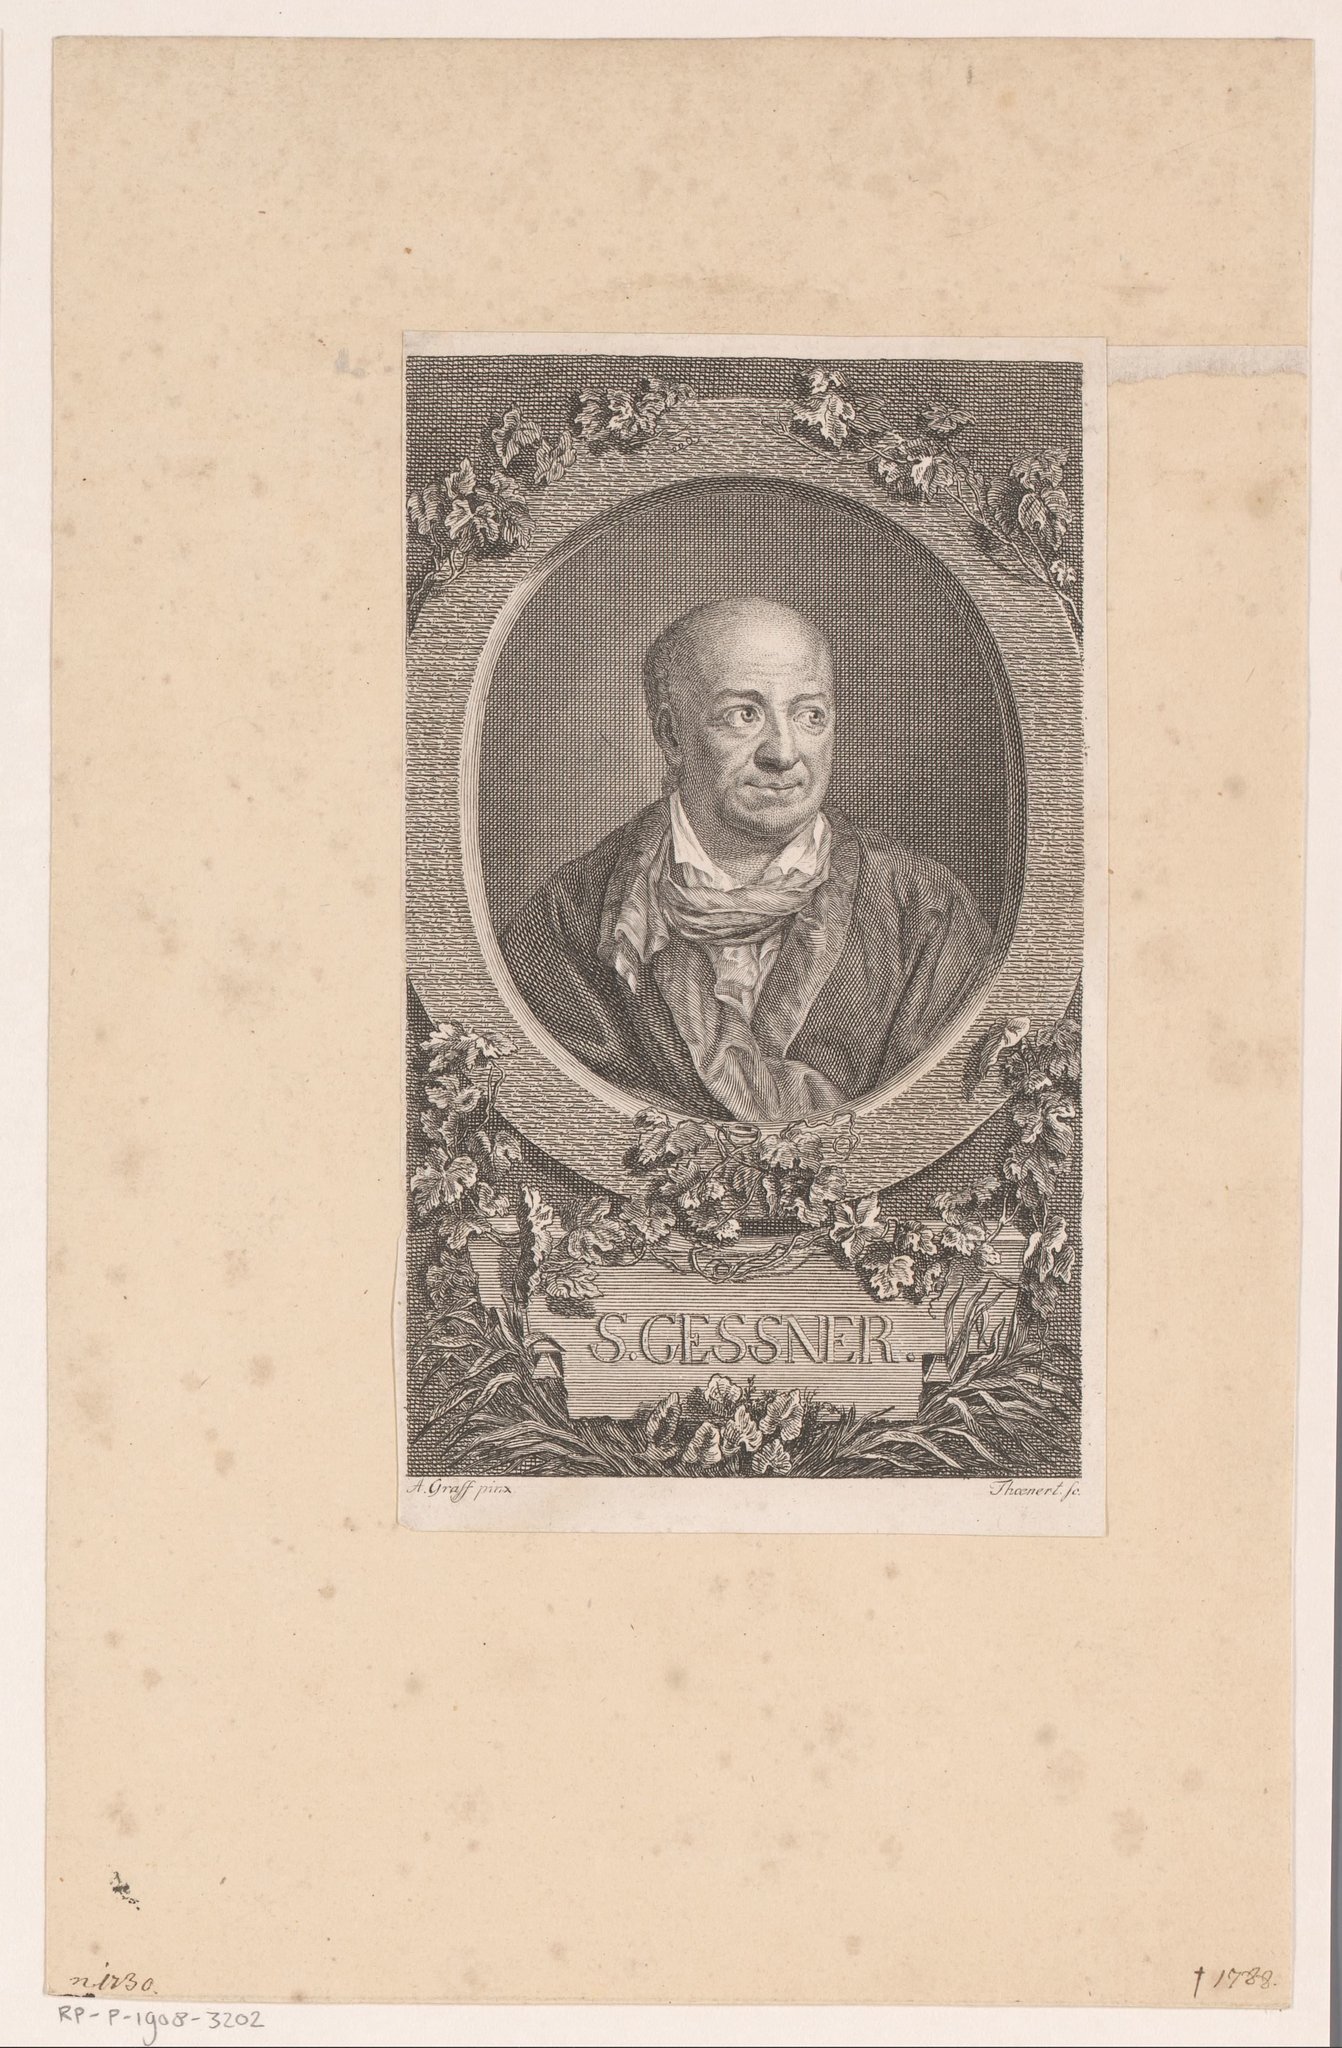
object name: print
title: Portret van Salomon Gesner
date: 1764-1814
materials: paper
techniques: engraving, etching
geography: germany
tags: painter, print maker, salomon gessner, historical persons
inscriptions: collector's mark: Lugt 2228